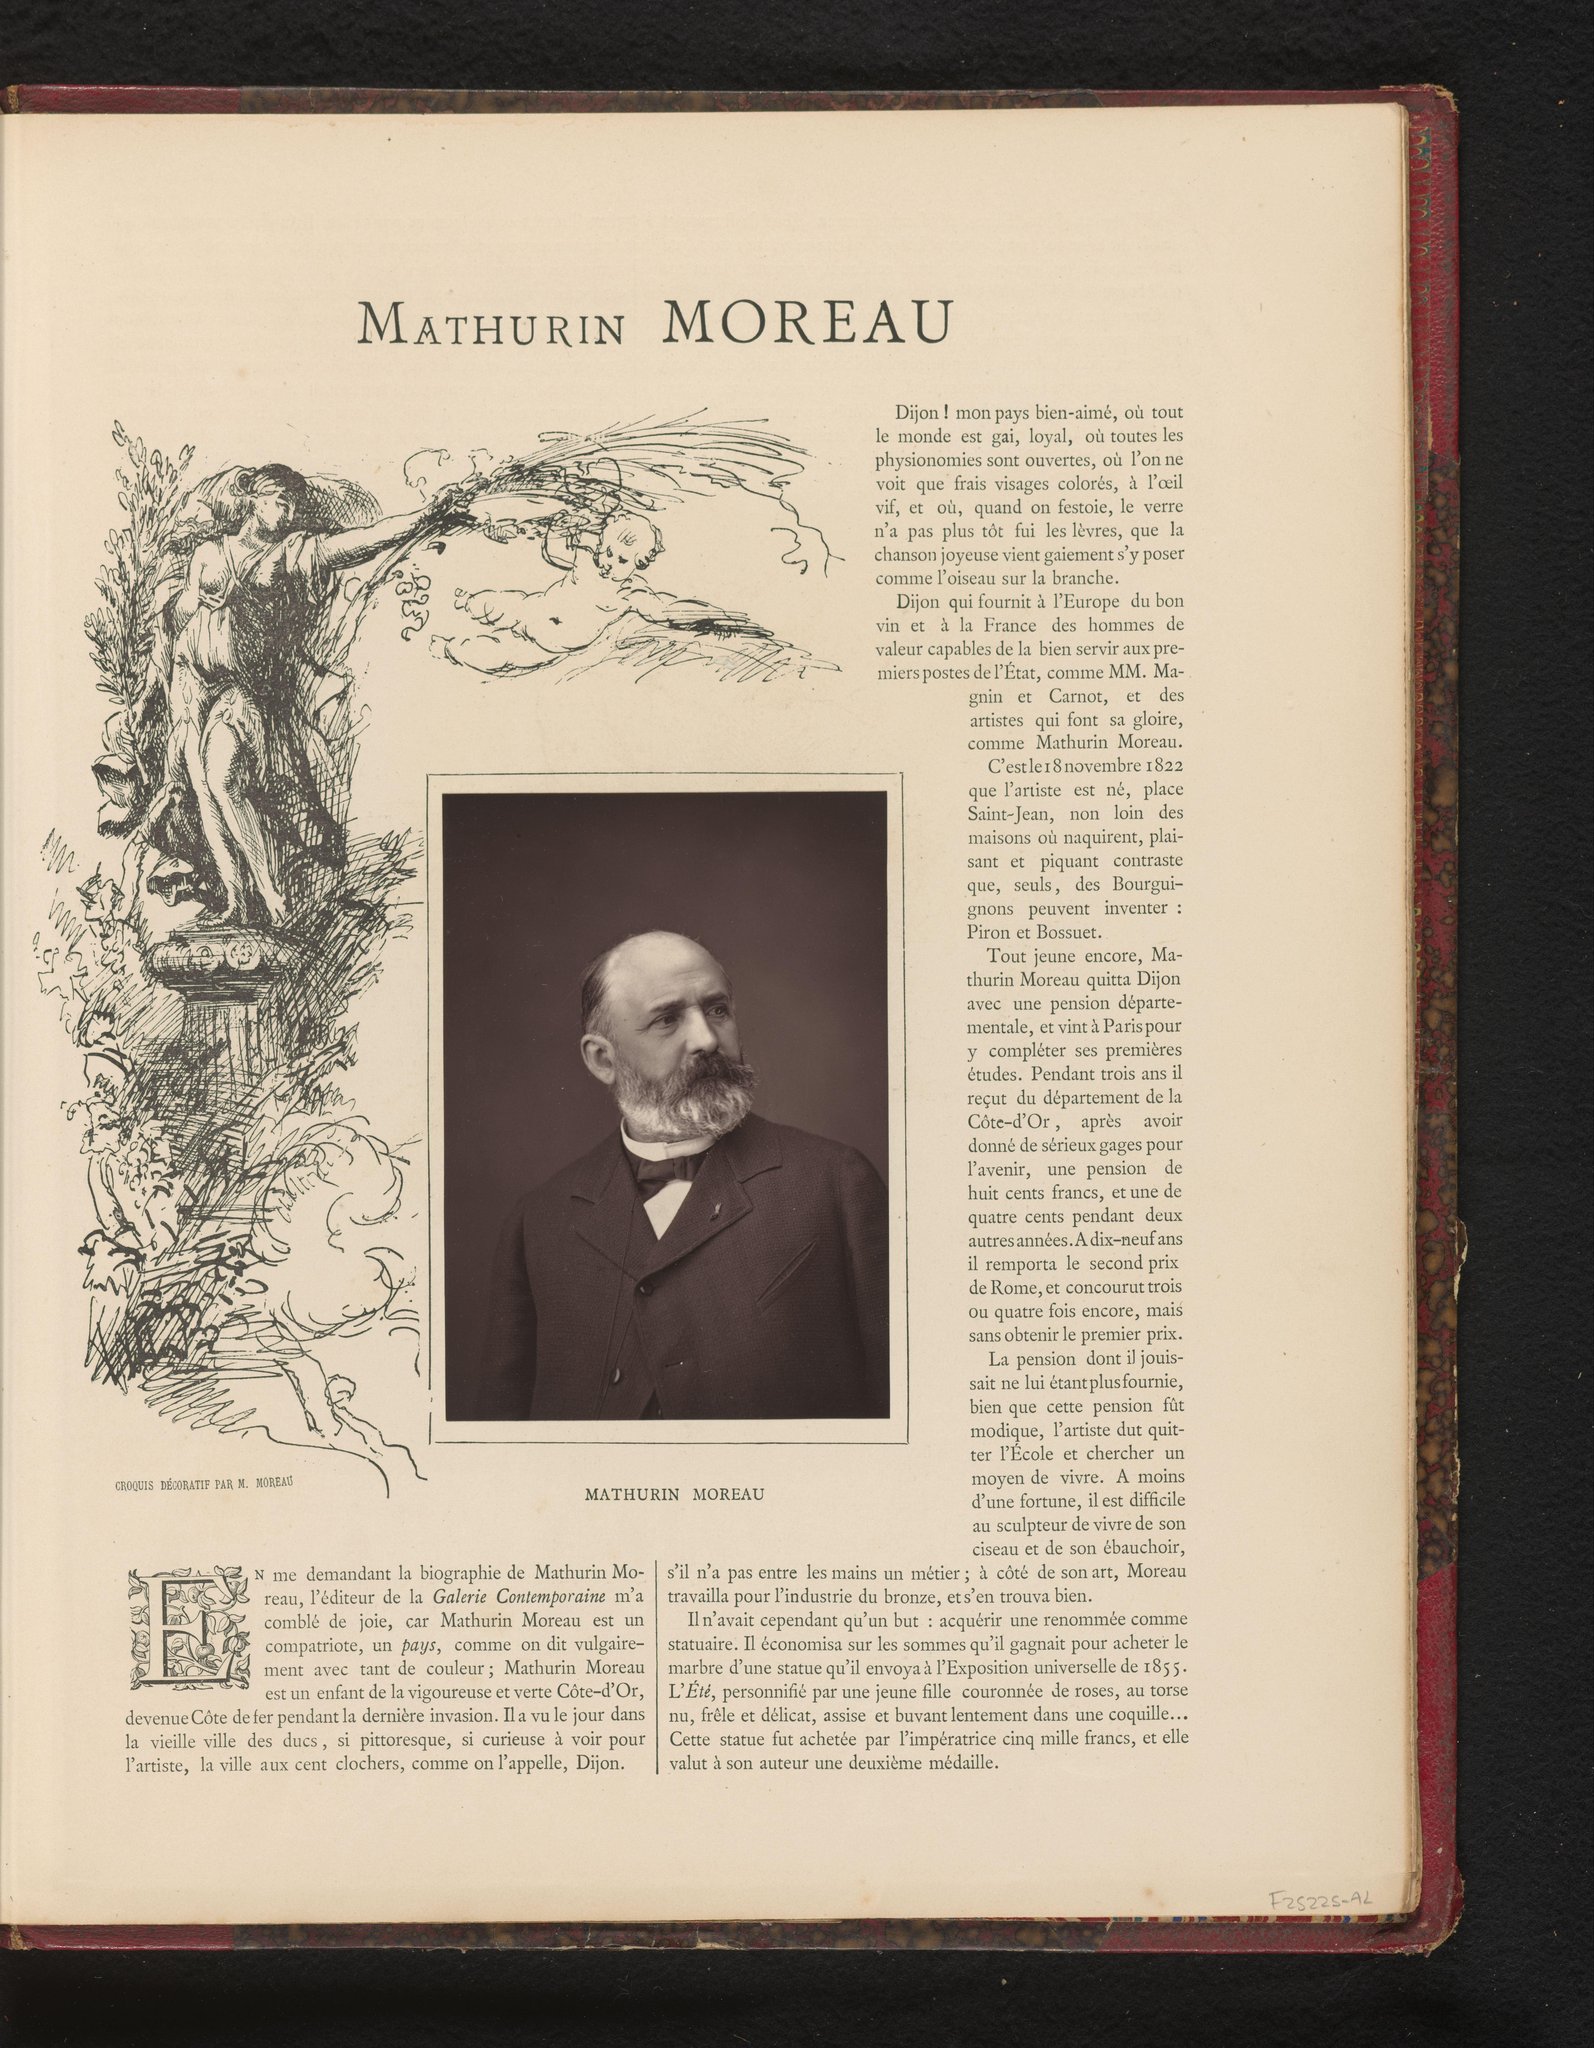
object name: photomechanical print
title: Portret van Mathurin Moreau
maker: Anonymous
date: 1876-1881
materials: paper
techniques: woodburytype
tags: paris, sculptor, mathurin moreau, historical persons